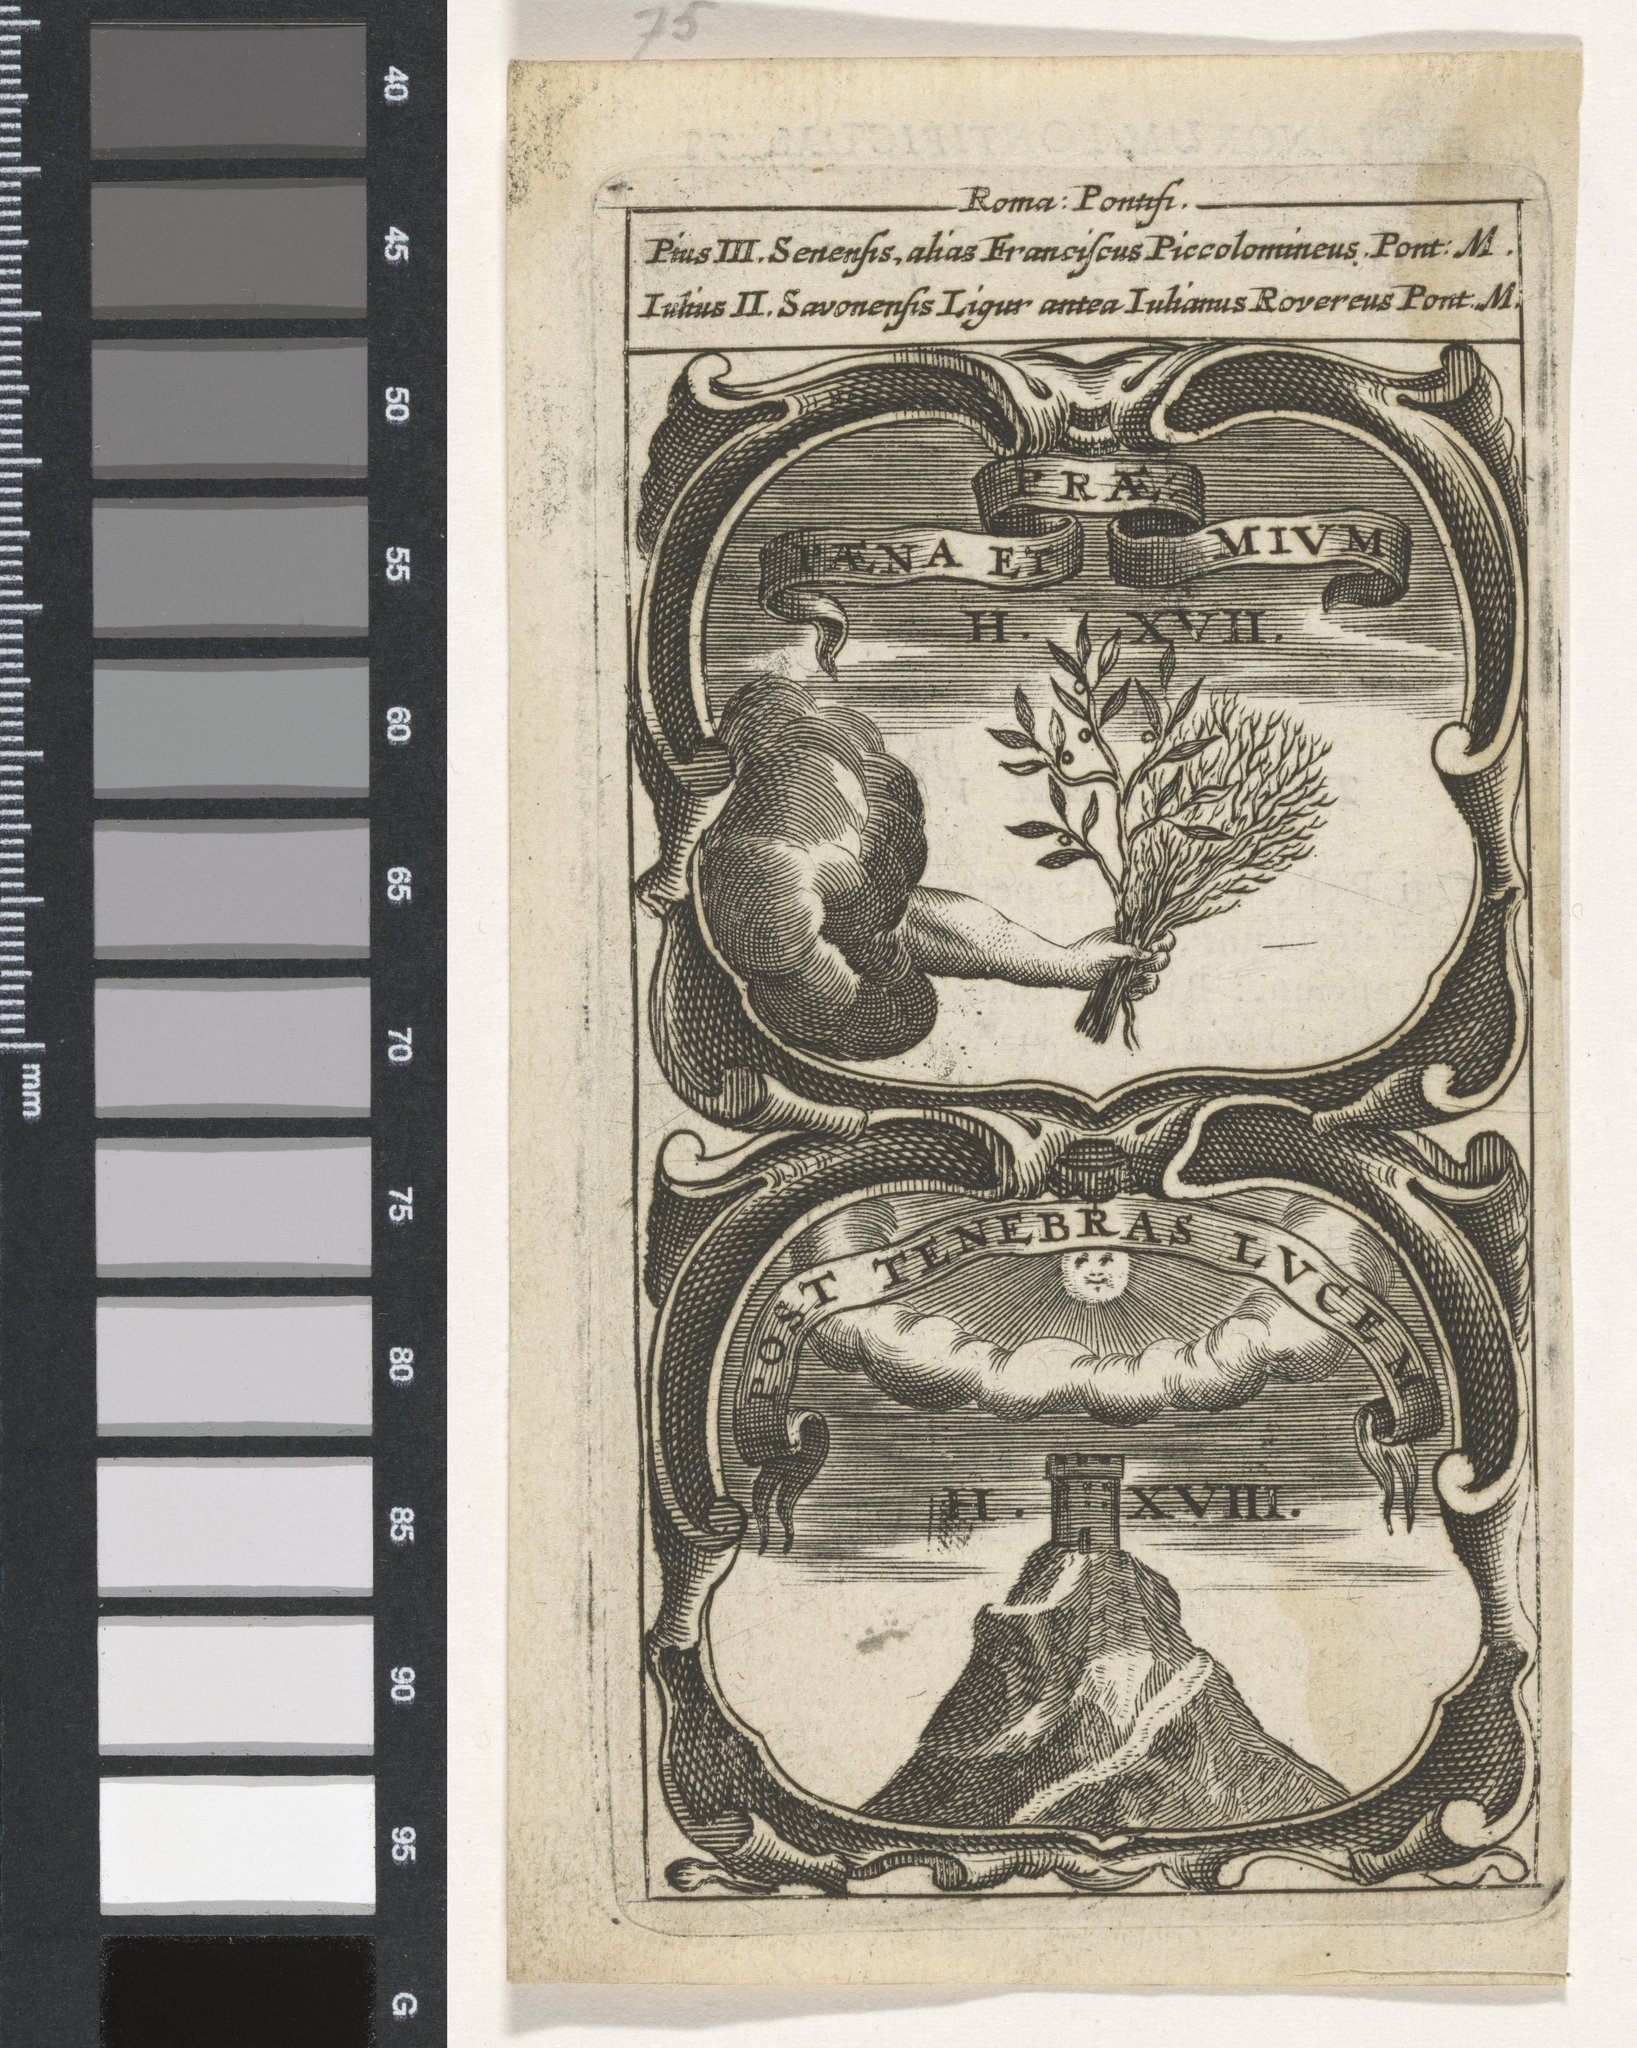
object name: book illustration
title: Paena Et Praemium / Post Tenebras Lucem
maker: Anonymous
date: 1666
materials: paper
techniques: engraving, letterpress printing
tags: rome, sun represented as face, wheel, etc., landscape with tower or castle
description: Pagina uit Jacob Typotius, Symbola Divina & Humana Pontificum Imperatorum Regum. Arnhem, J.F. Hagen, 1666 of uit de titeluitgave van 1669 of 1679. Het werk van Typotius werd voor het eerst uitgegeven in 1601 met prenten van Aegidius Sadeler.